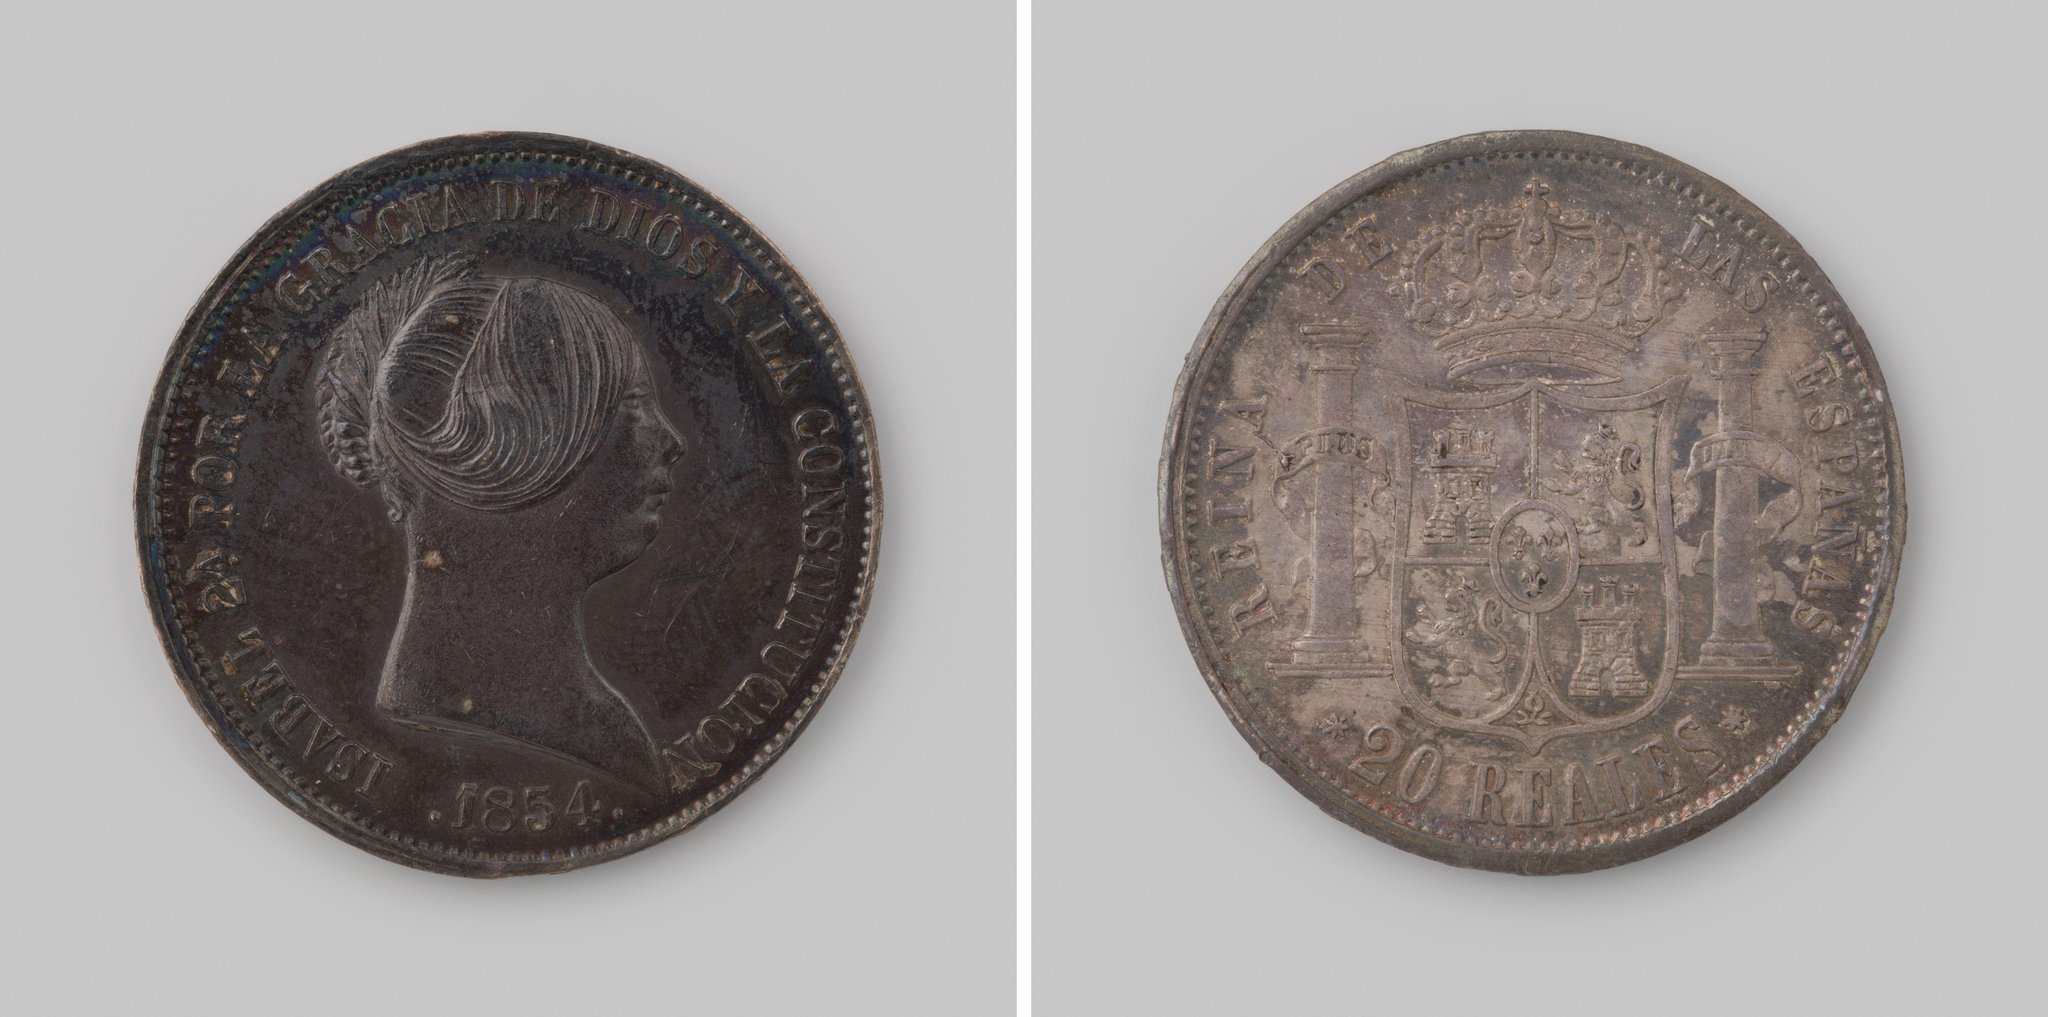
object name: twintig reaal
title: Piaster of duro van twintig reaal uit Spanje van koningin Isabel II, 1854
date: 1854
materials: silver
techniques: striking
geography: madrid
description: Zilveren munt. Voorzijde: hoofd van de koningin naar rechts. Daaronder jaartal. Keerzijde: tussen twee pilaren, waarop lint met spreuk, gekroond wapenschild. Waarde-aanduiding: 20 reales onderaan. Opliggend randschrift.